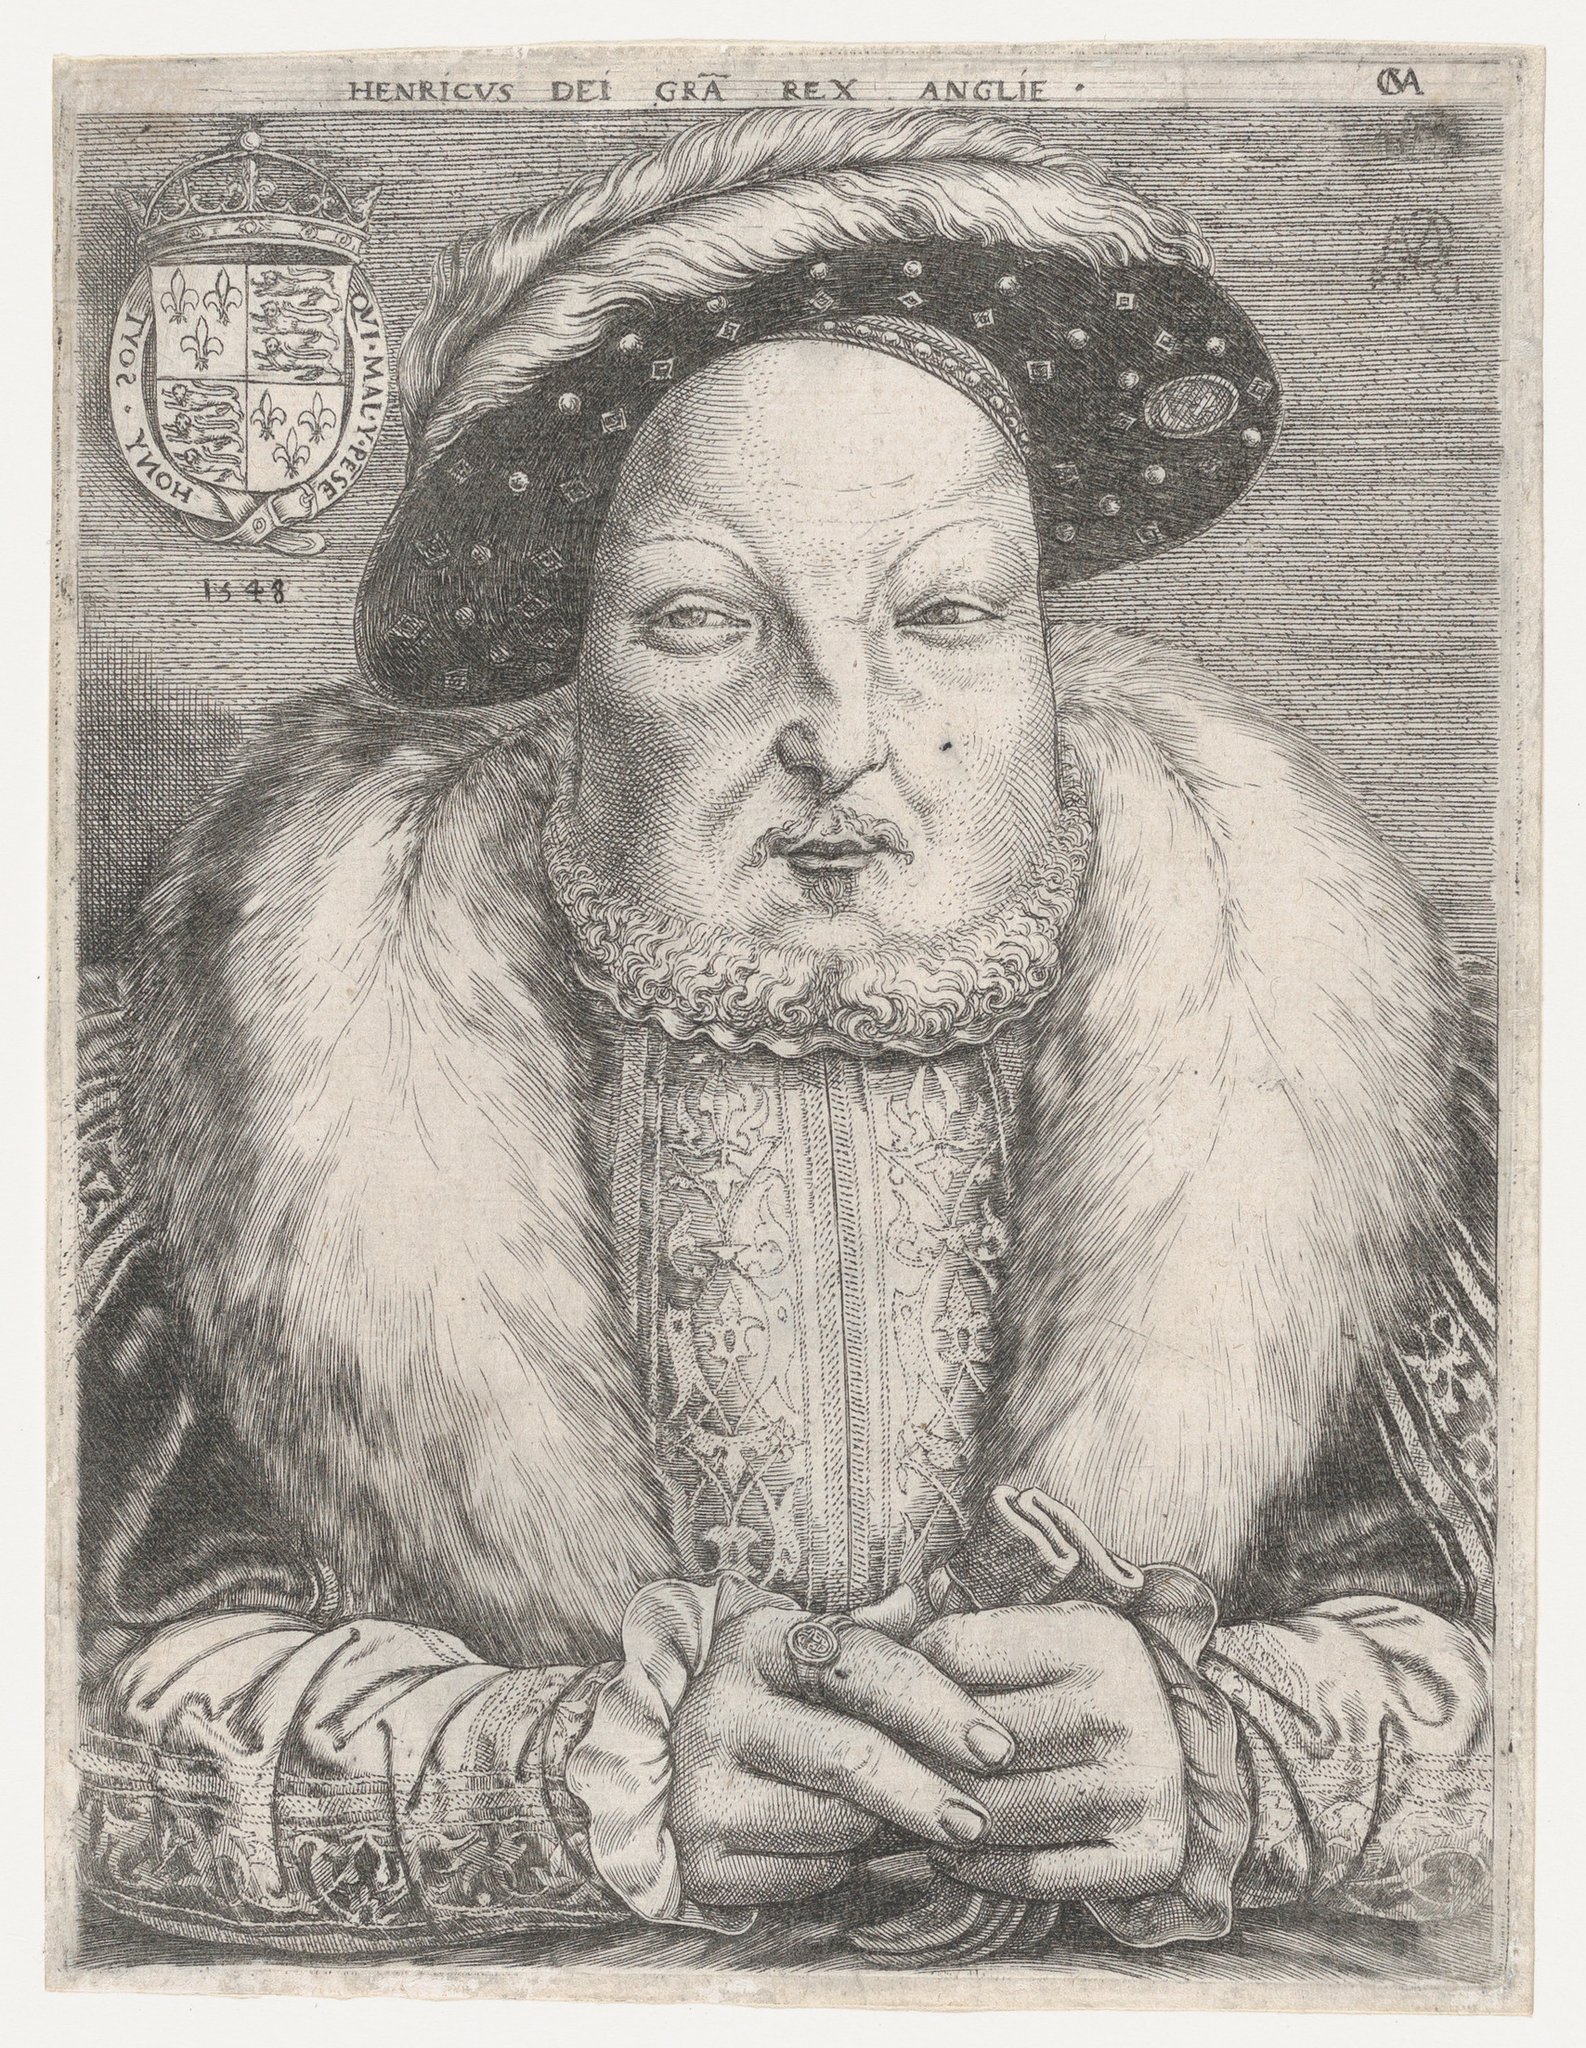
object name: print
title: Portrait of Henry VIII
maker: cornelis massys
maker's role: artist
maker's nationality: netherlandish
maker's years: 1510-1557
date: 1547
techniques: engraving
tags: henry viii,kings,men,portraits